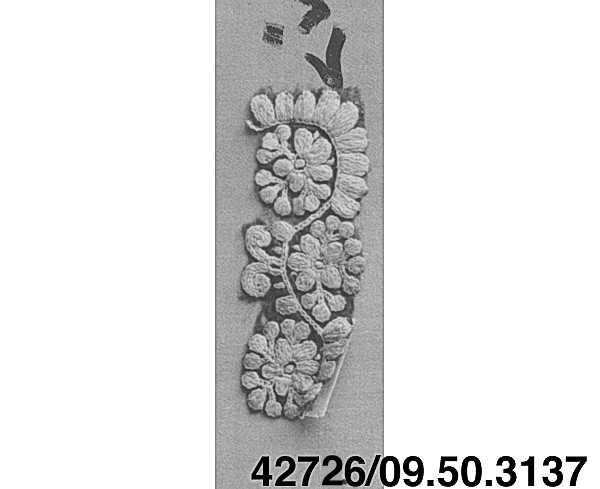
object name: fragment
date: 1701-1800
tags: flowers,leaves